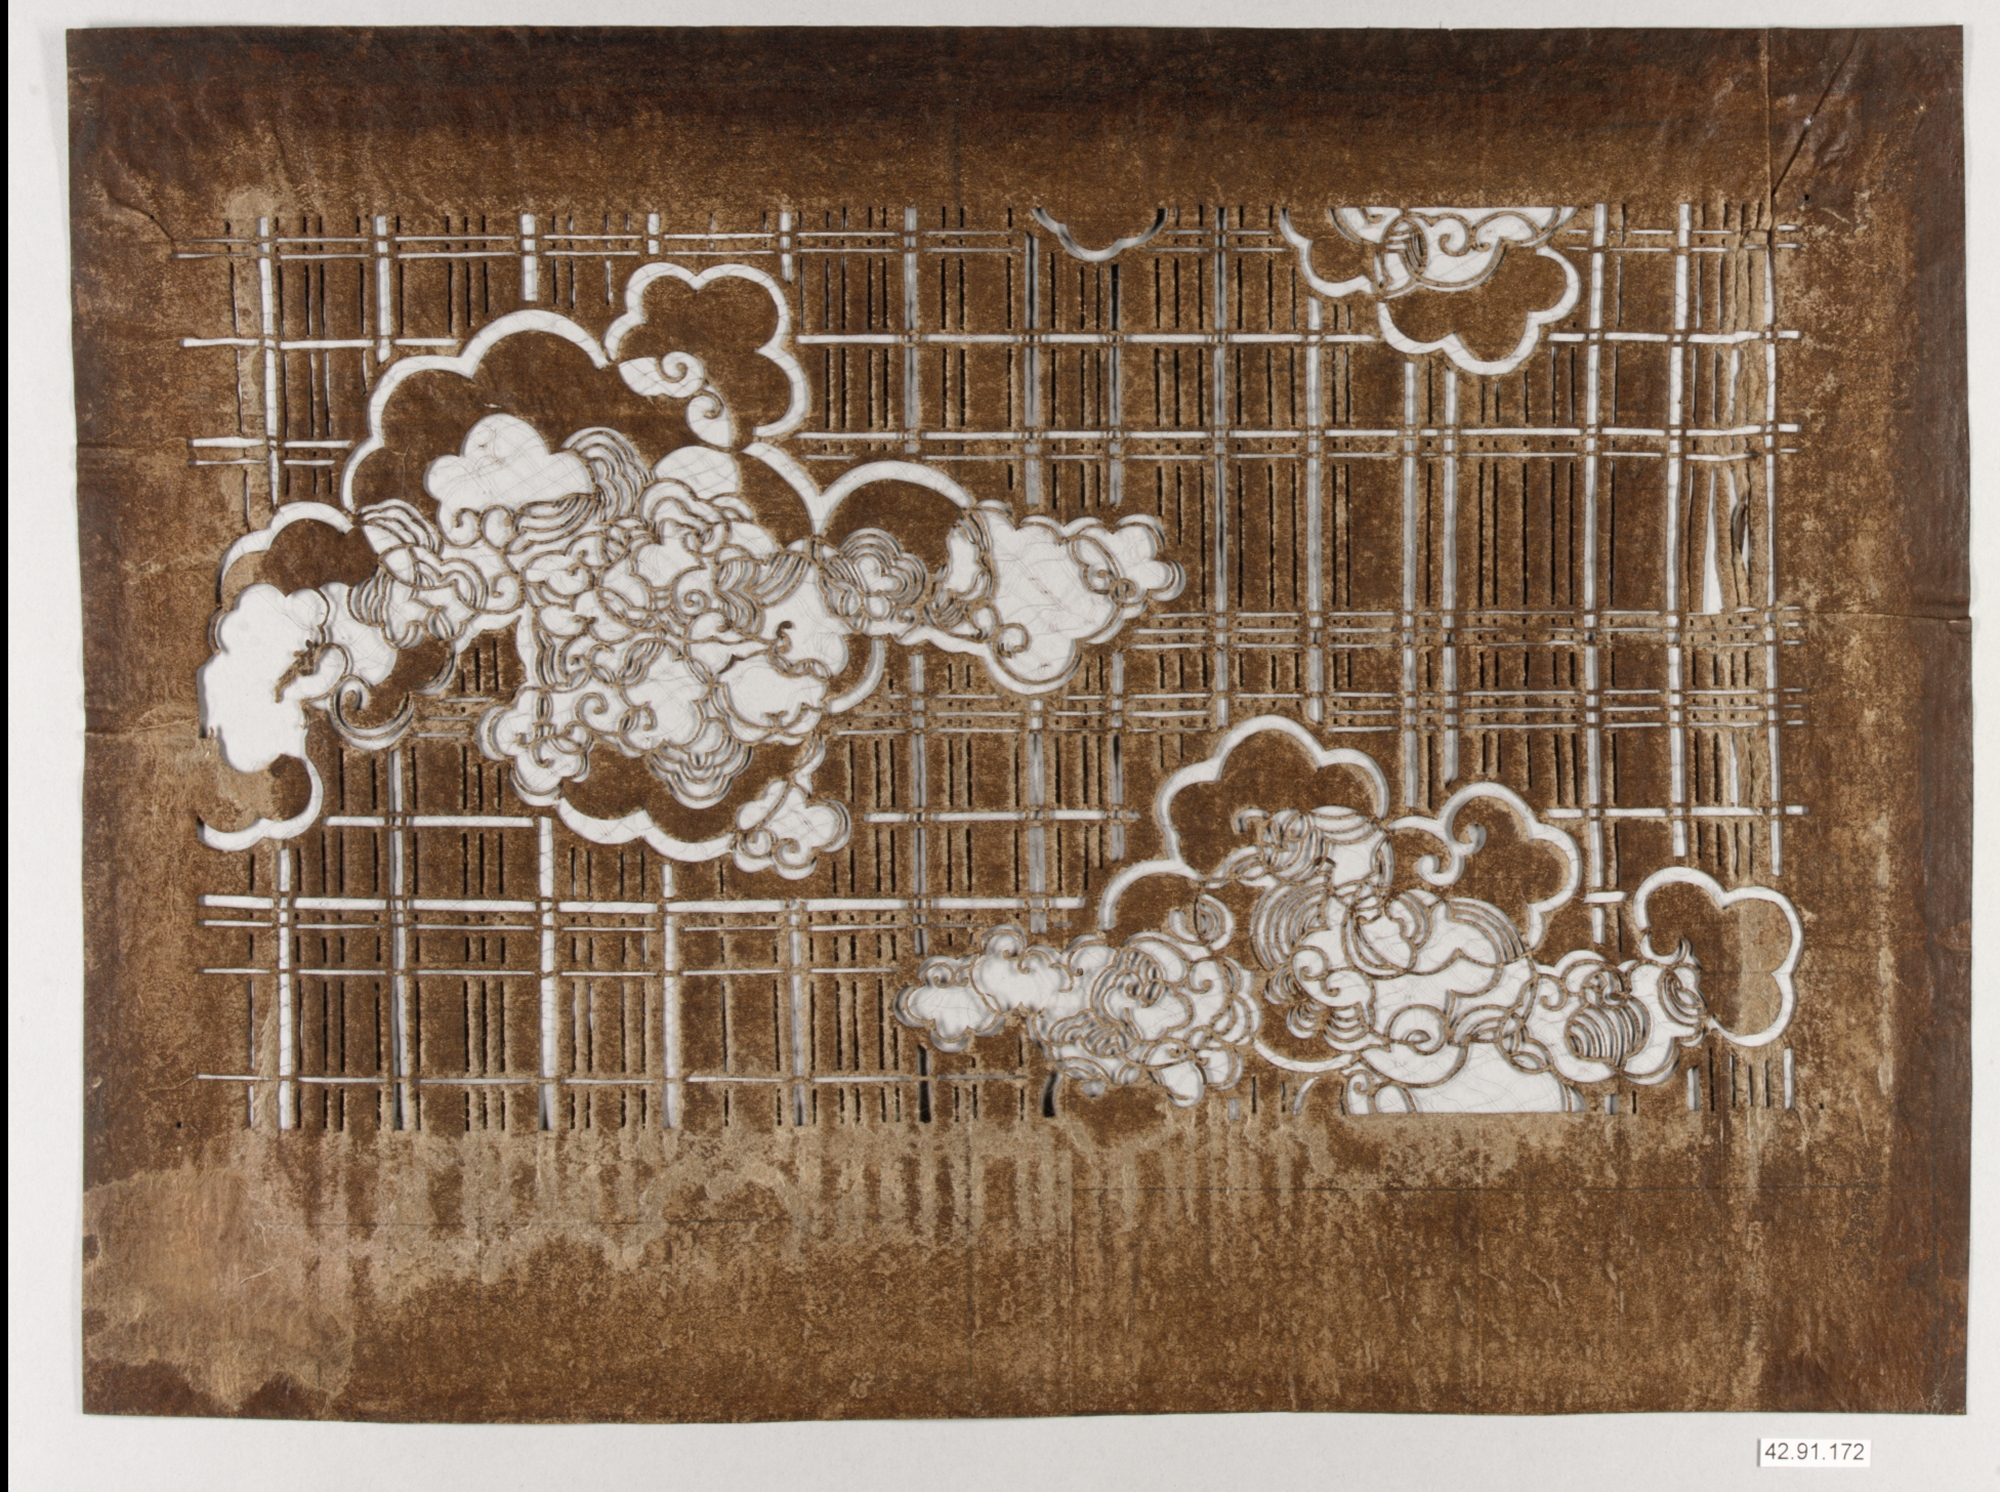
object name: stencil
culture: japanese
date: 1801-1900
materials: paper, silk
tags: clouds